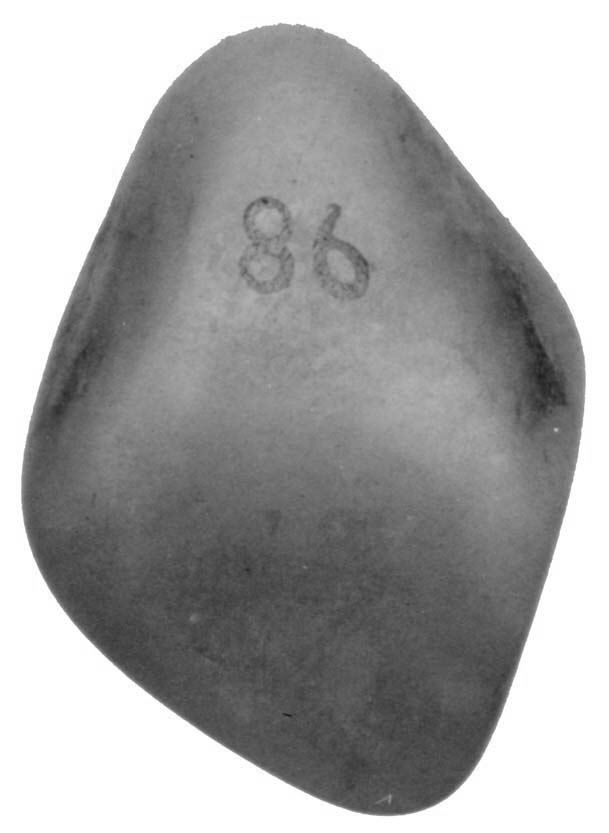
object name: pebble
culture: chinese or turkestani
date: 1902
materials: jade